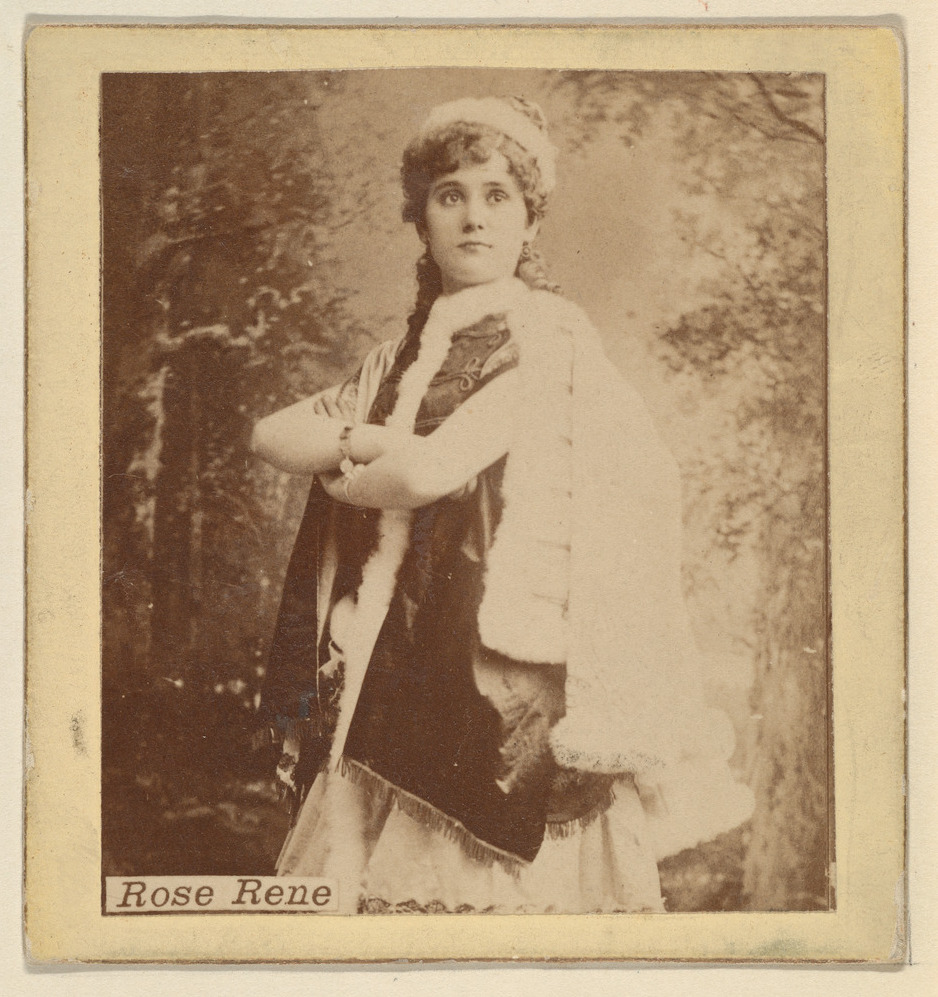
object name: photograph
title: Rose Rene, from the Actresses series (N246), Type 2, issued by Kinney Brothers to promote Sporting Extra Cigarettes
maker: kinney brothers tobacco company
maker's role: publisher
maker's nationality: american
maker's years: 1869-2011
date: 1890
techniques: albumen silver print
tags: portraits,women,actresses